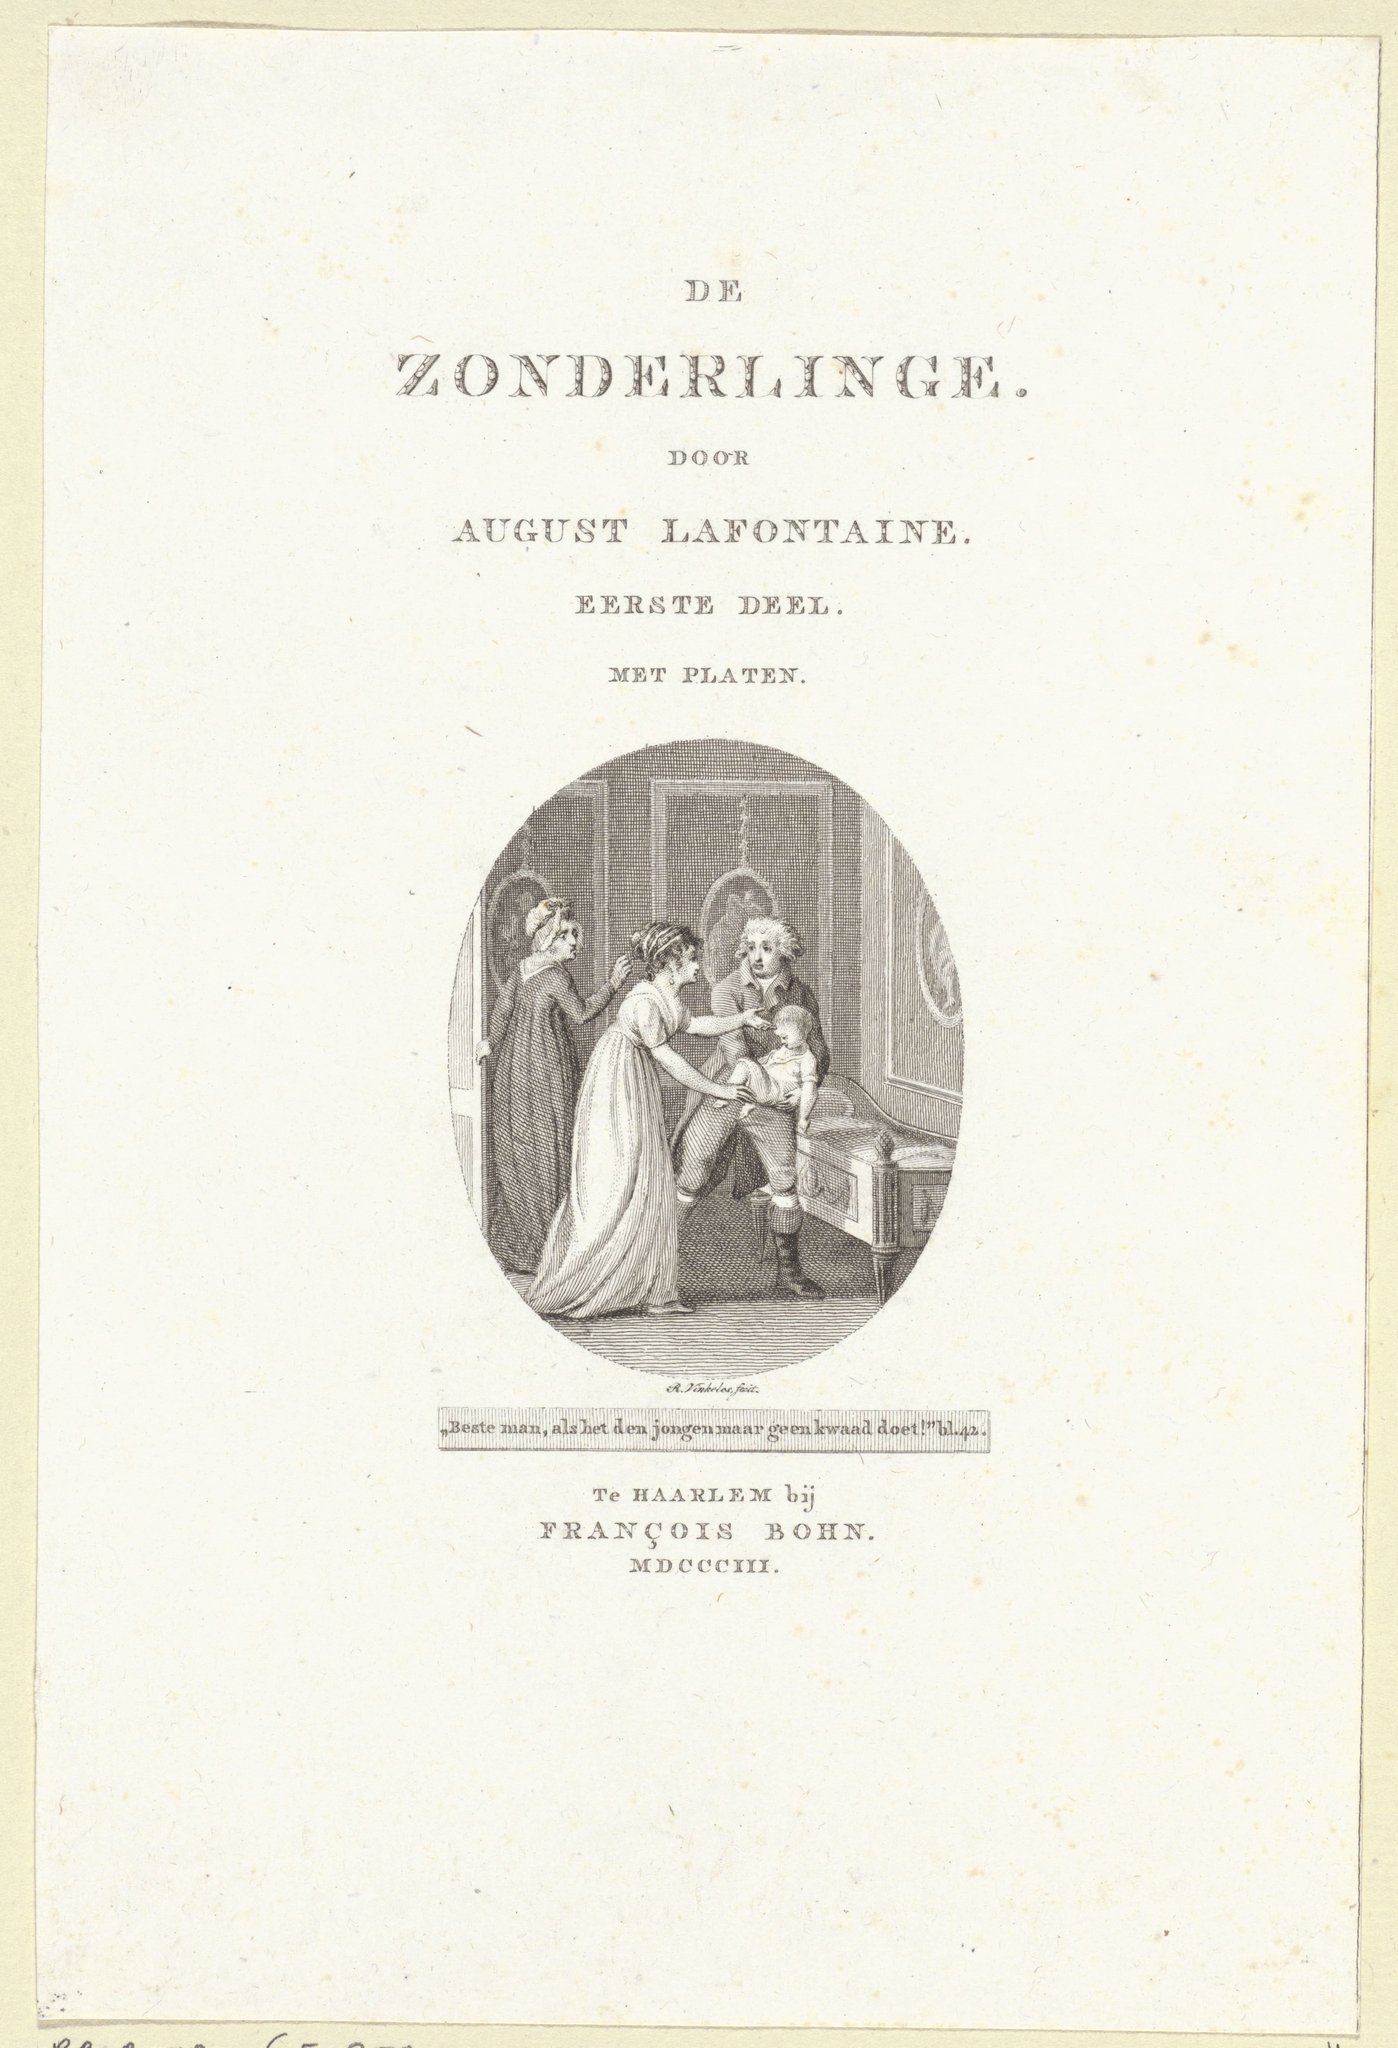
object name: titelblad, titelpagina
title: Titelpagina voor: August Lafontaine, 'De Zonderlinge', 1803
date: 1803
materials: paper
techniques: engraving, etching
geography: amsterdam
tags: child, bed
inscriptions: collector's mark: Lugt 240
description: Titelpagina voor: Lafontaine, August Heinrich Julius. De Zonderlinge. Haarlem: François Bohn, 1803.